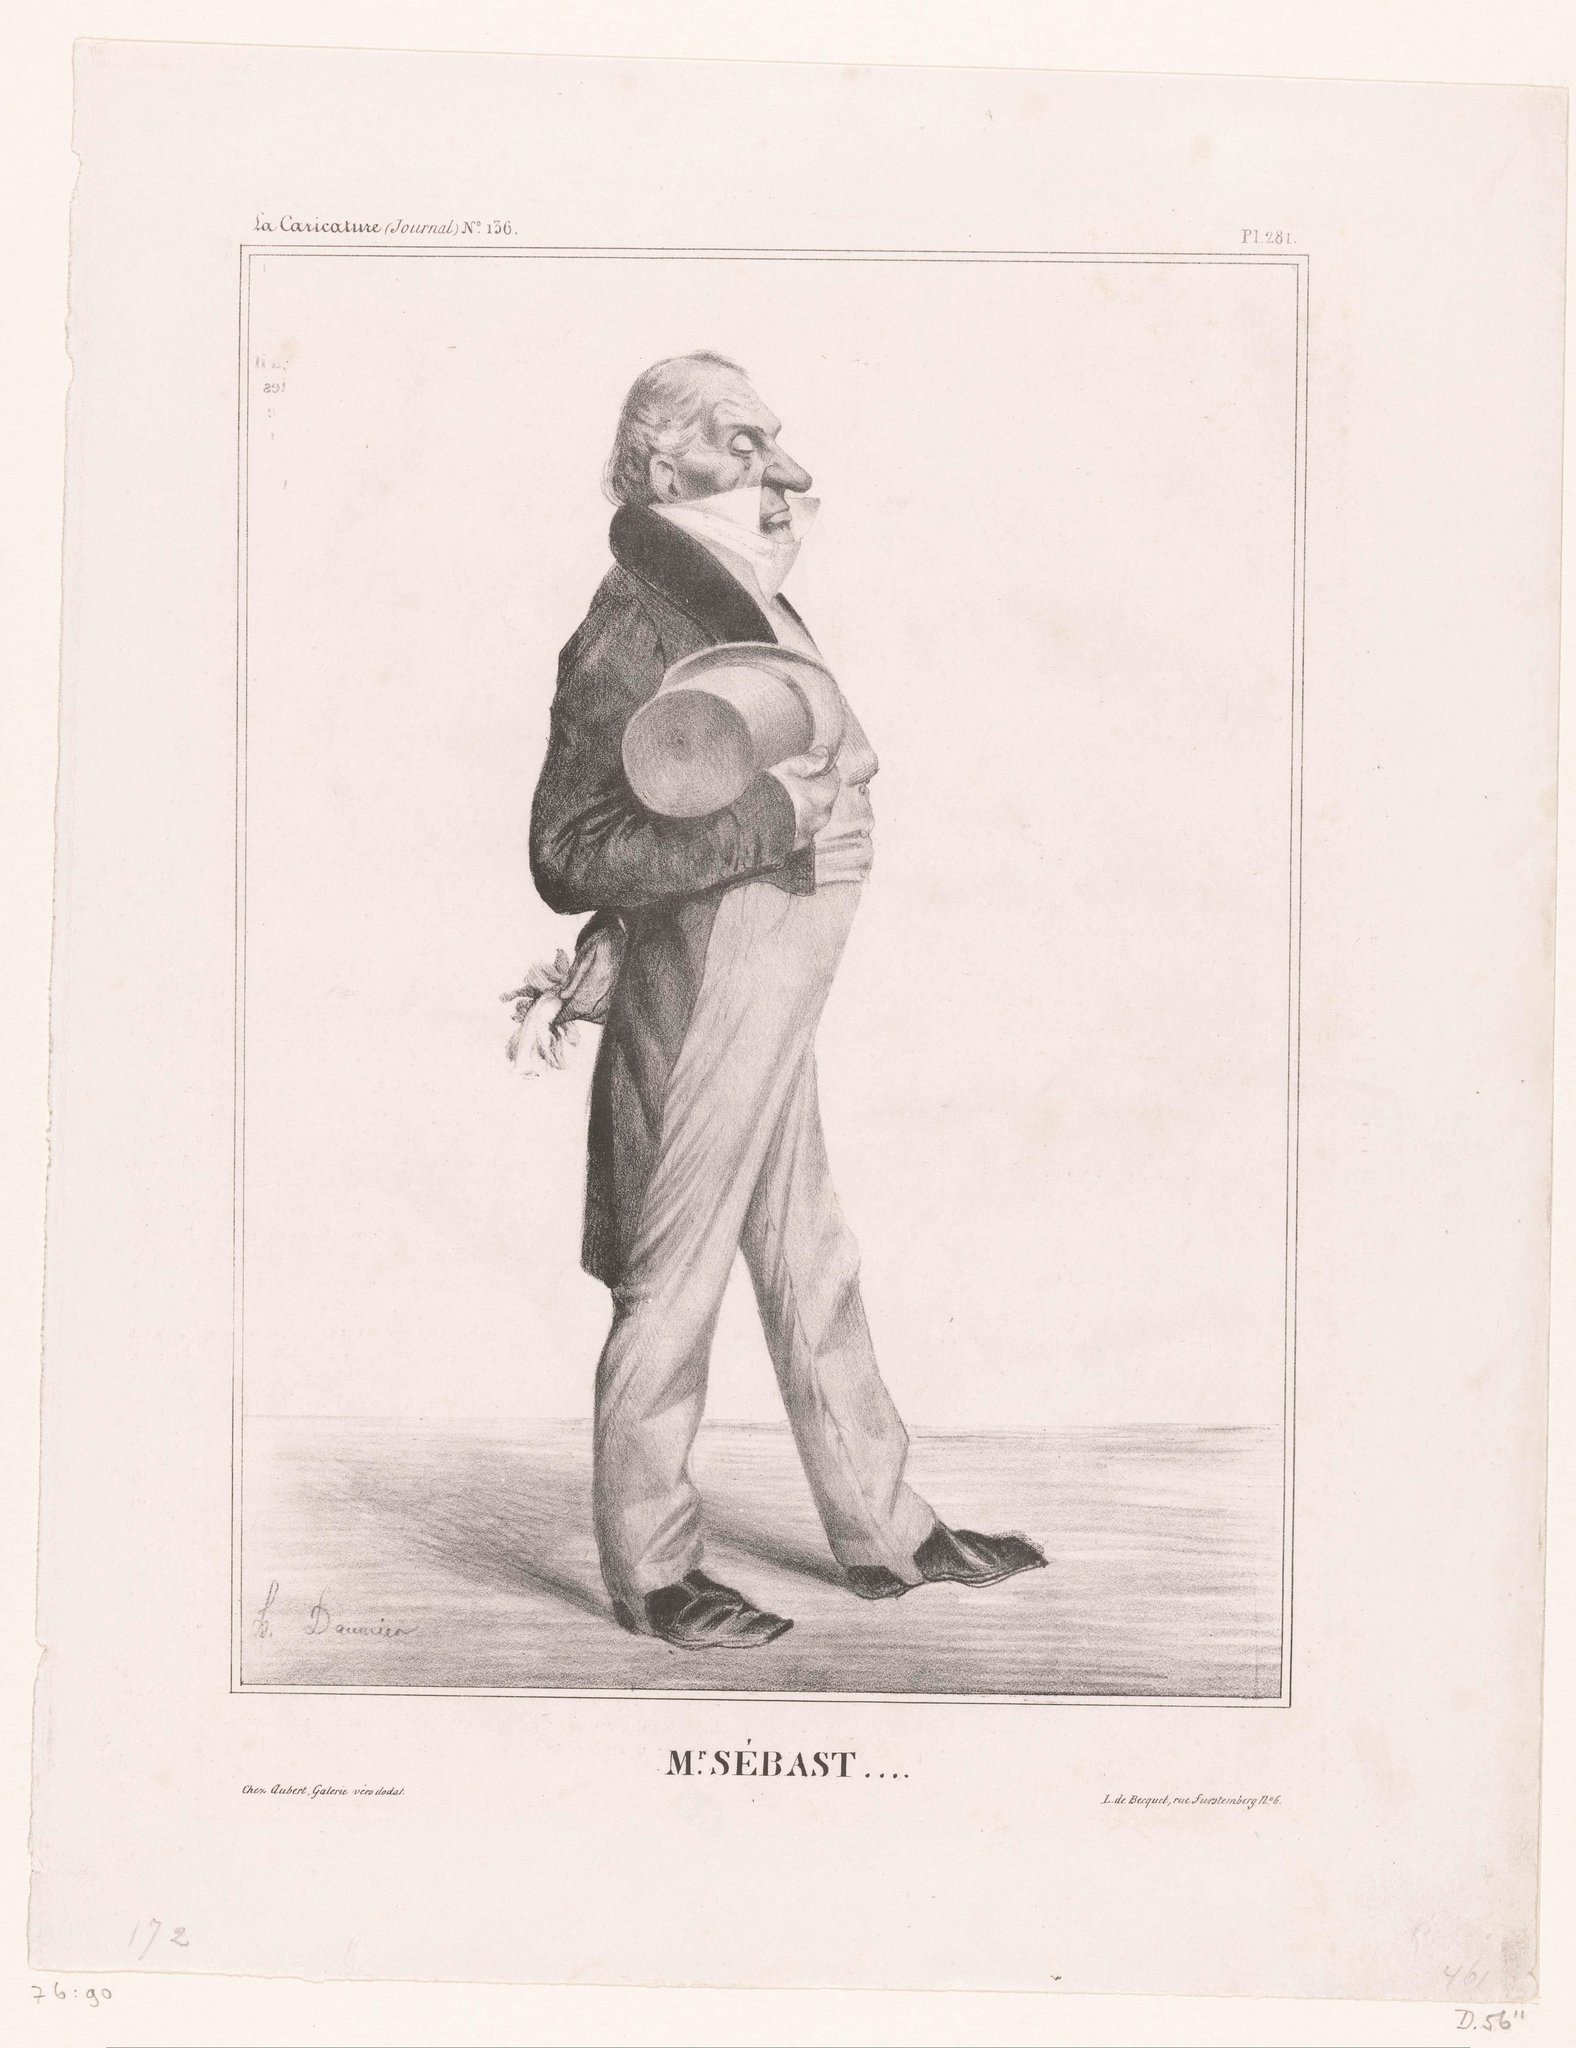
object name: cartoon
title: Karikatuur van Horace Sébastiani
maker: honoré daumier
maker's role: draughtsman, painter, print maker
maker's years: 1808-1879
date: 1833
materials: paper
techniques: lithograph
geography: paris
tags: paris, politician, caricatures (human types), historical persons, political caricatures and satires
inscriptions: collector's mark: Lugt 4731, number: ‘461’, collector's mark: Lugt 2228a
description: Prent gepubliceerd in: La Caricature, 13 juni 1833, nr. 136, pl. 281.